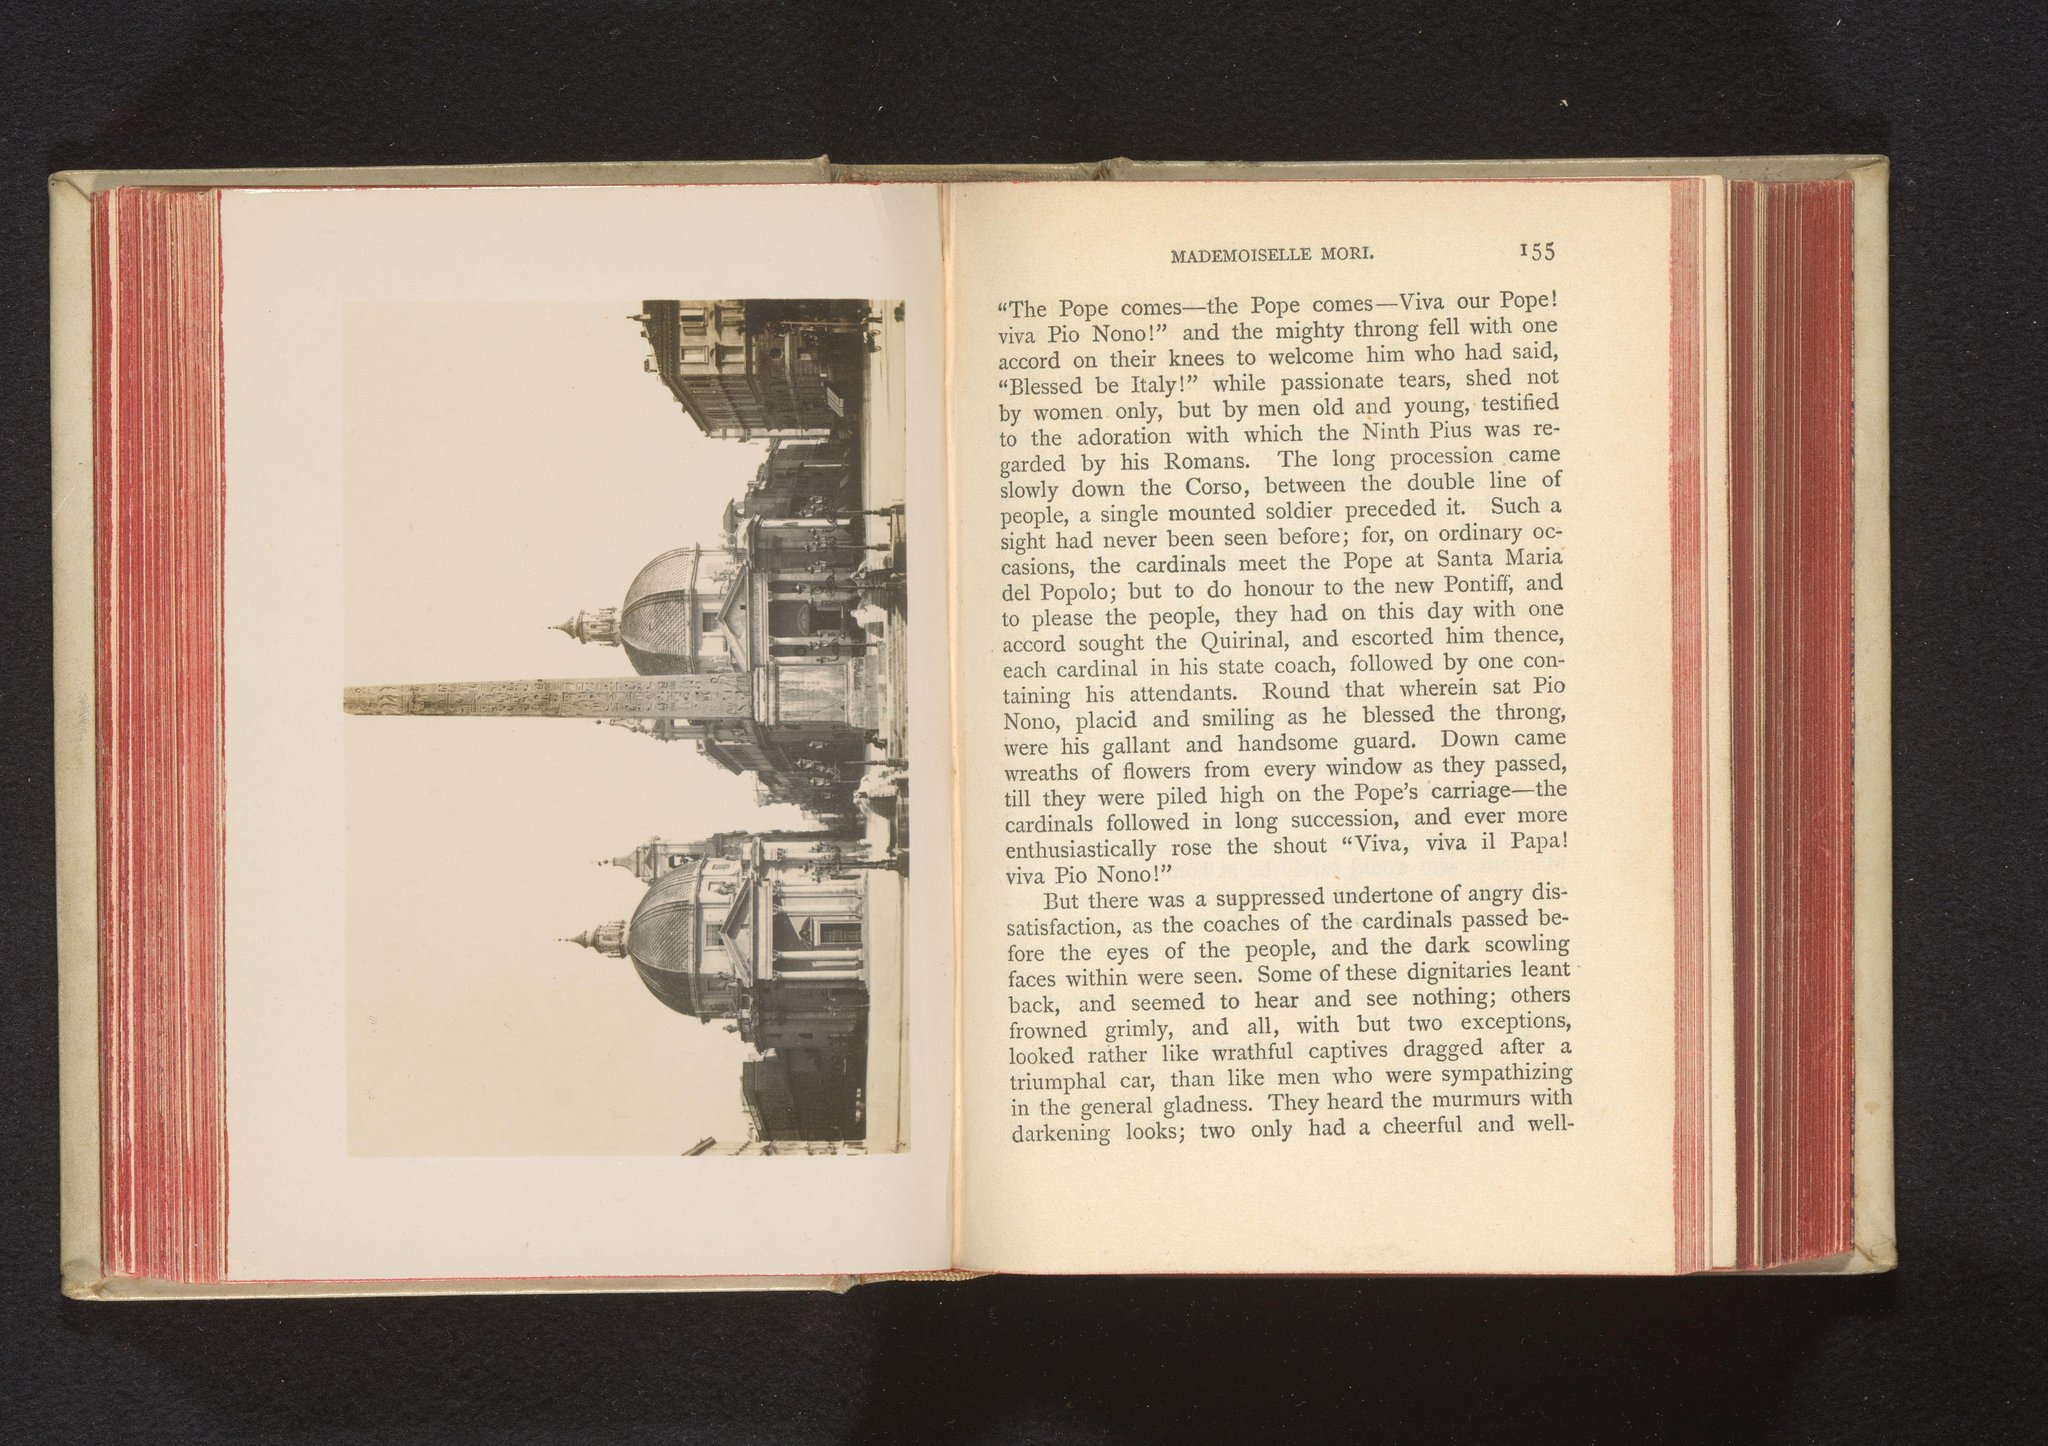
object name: photograph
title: Obelisk op het Piazza del Popolo te Rome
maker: Anonymous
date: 1852-1862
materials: photographic support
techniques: gelatin silver print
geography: piazza del popolo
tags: square, place, circus, etc., obelisk, needle